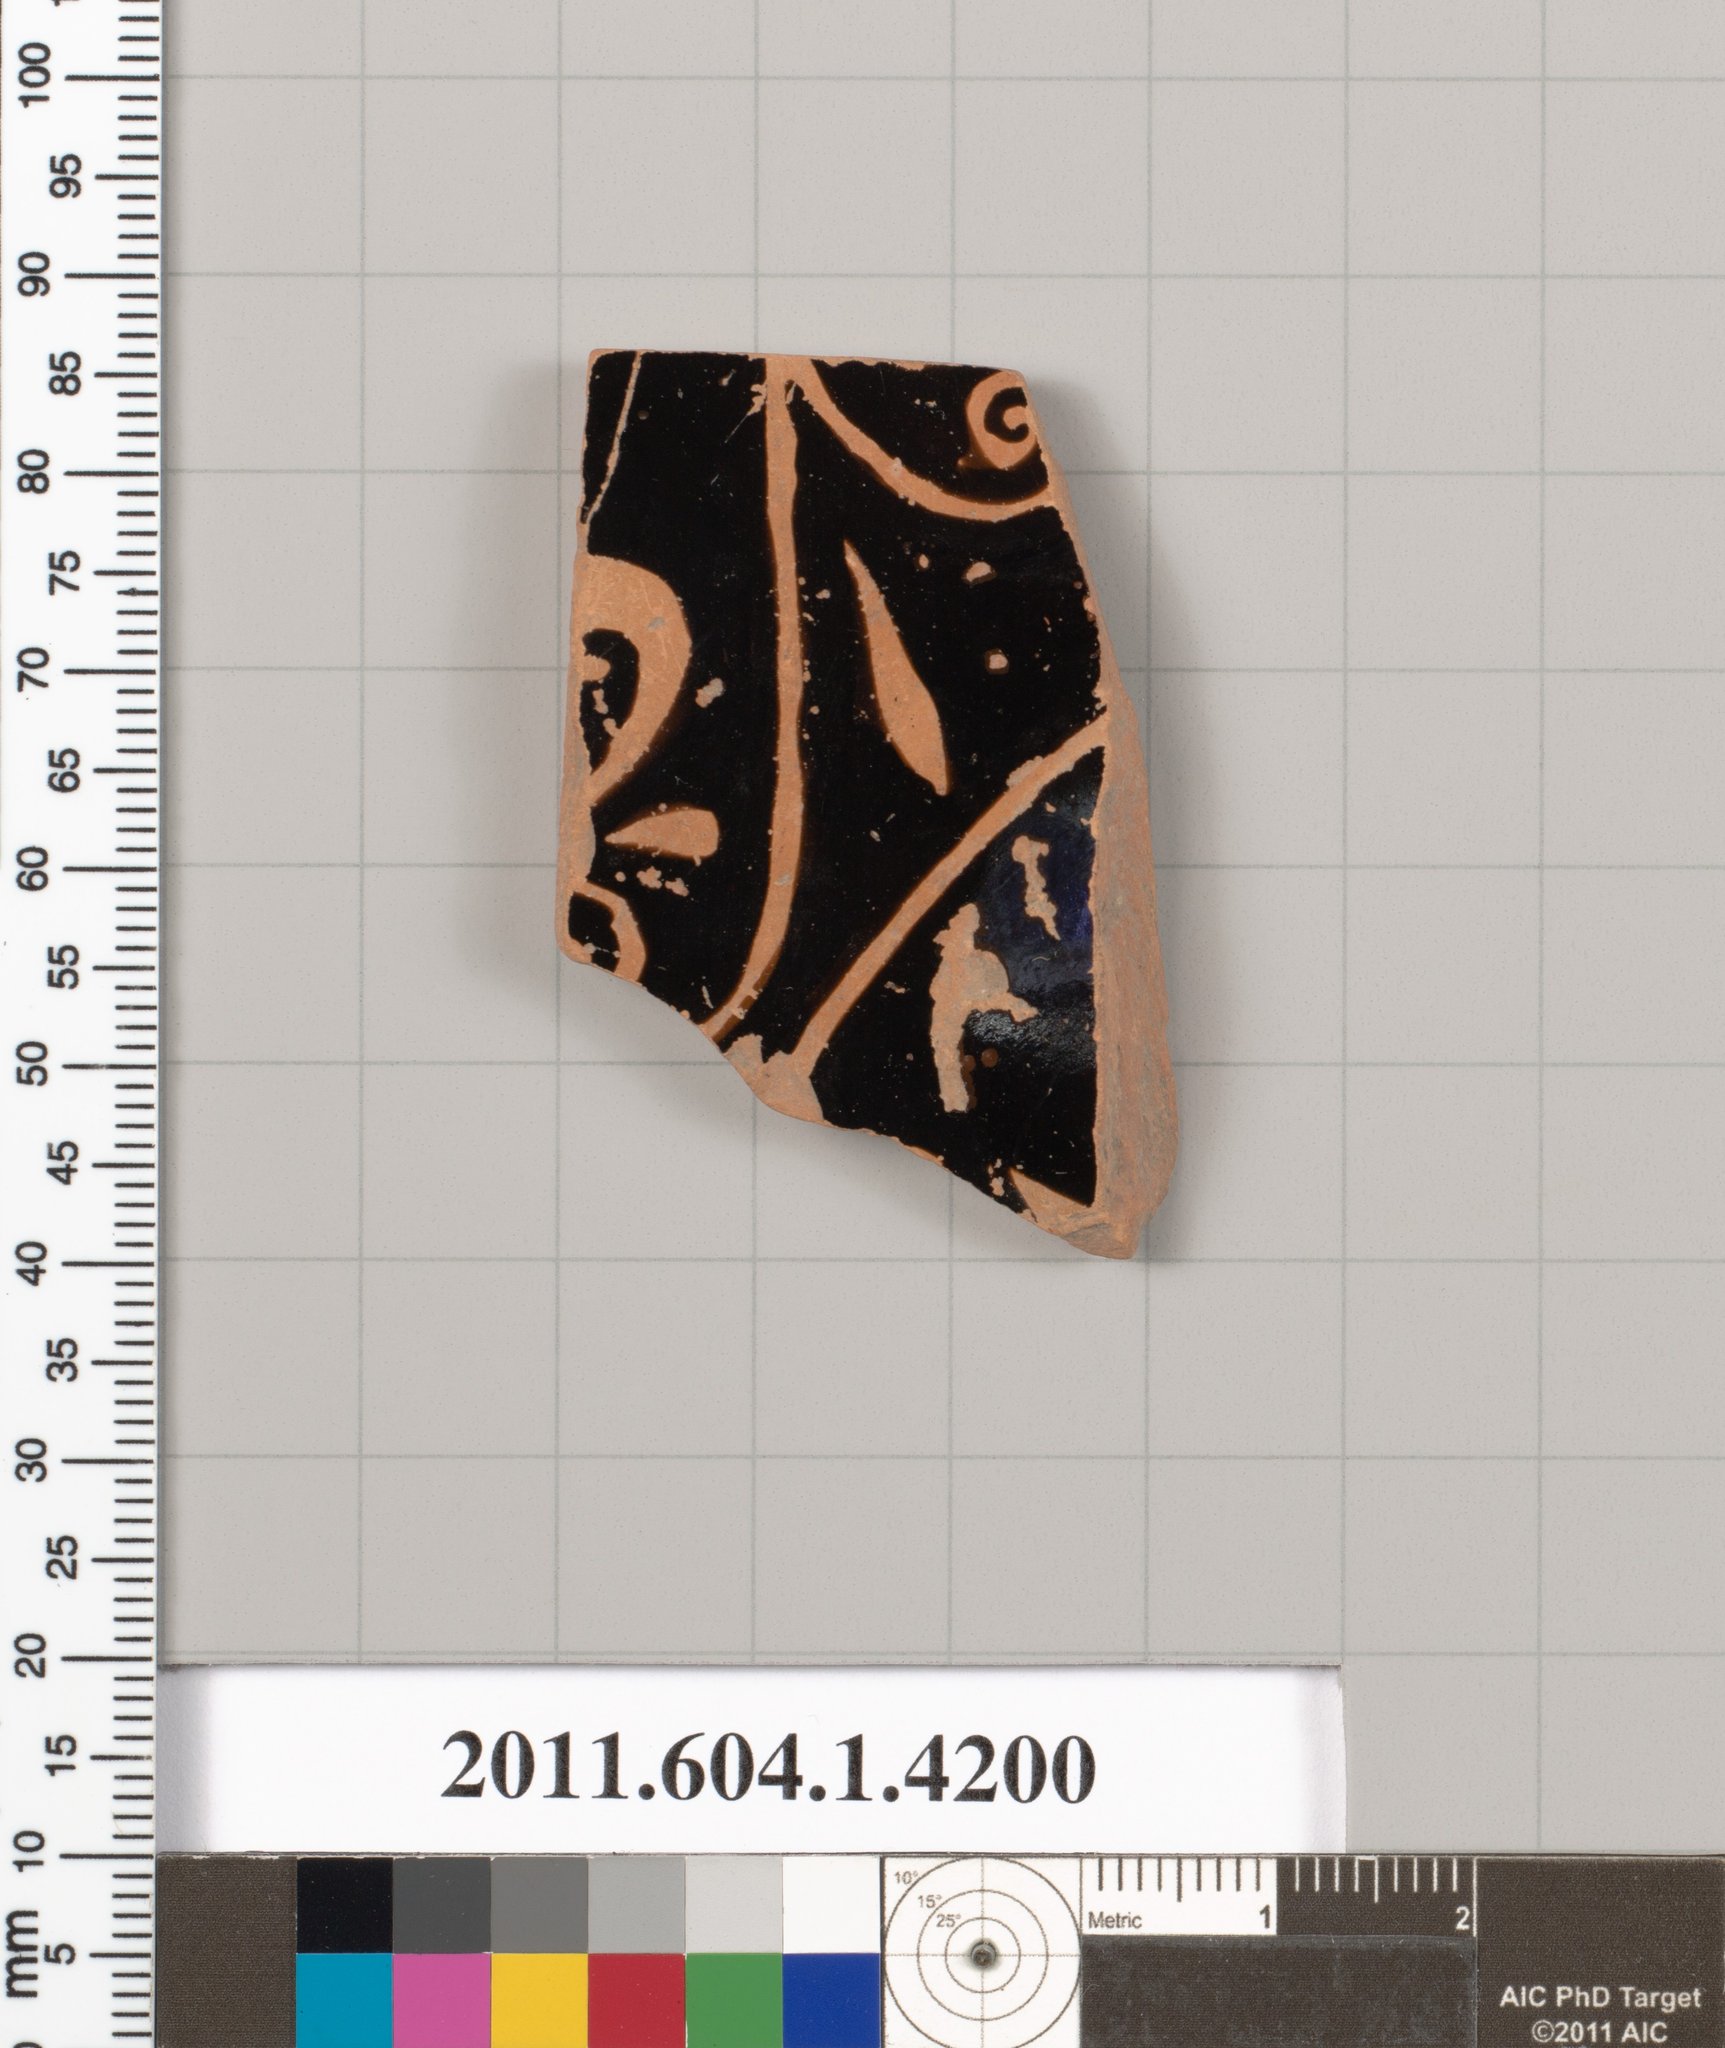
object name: kylix fragment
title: Terracotta fragment of a kylix (drinking cup)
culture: greek, attic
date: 500-476 BCE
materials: terracotta